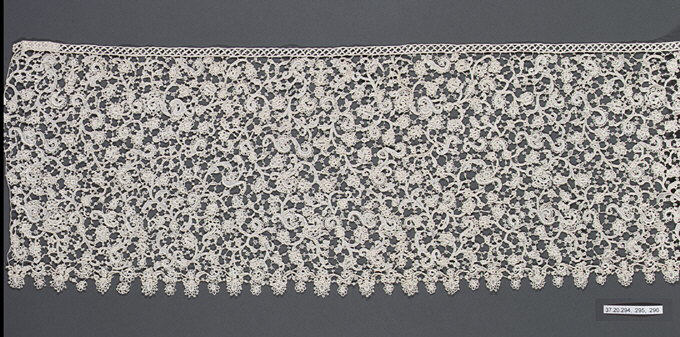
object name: border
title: Border (one of three joined)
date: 1701-1733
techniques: lace